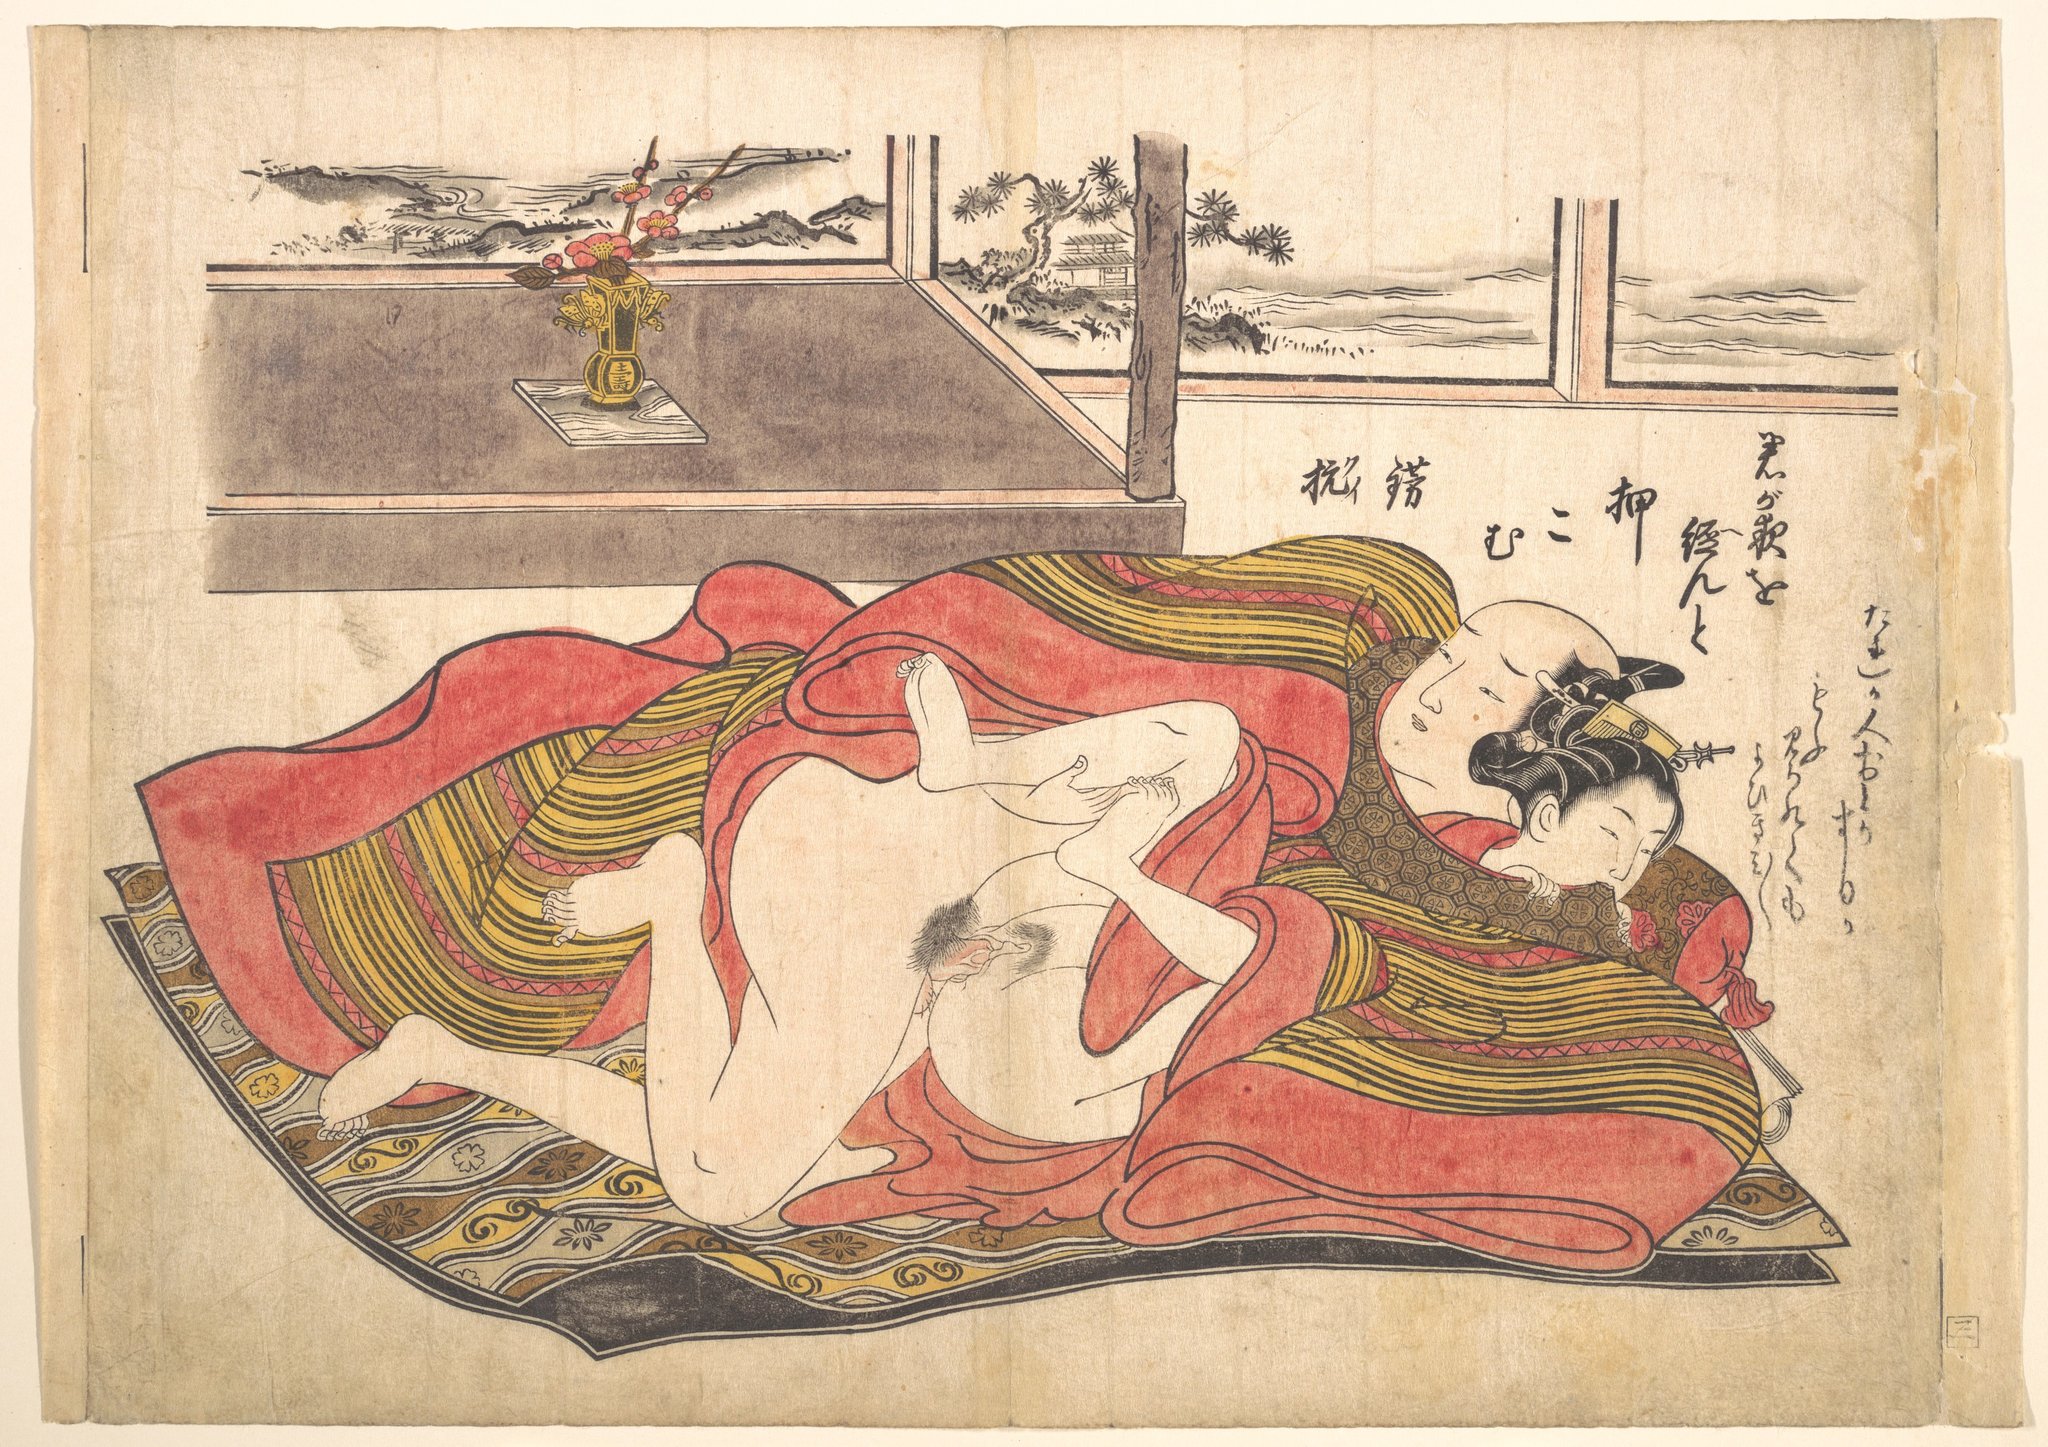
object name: print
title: Bedroom Scene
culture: japanese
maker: okumura masanobu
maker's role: artist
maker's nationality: japanese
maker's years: 1686-1764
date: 1739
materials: ink, paper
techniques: hand coloring, woodblock print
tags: male nudes,female nudes